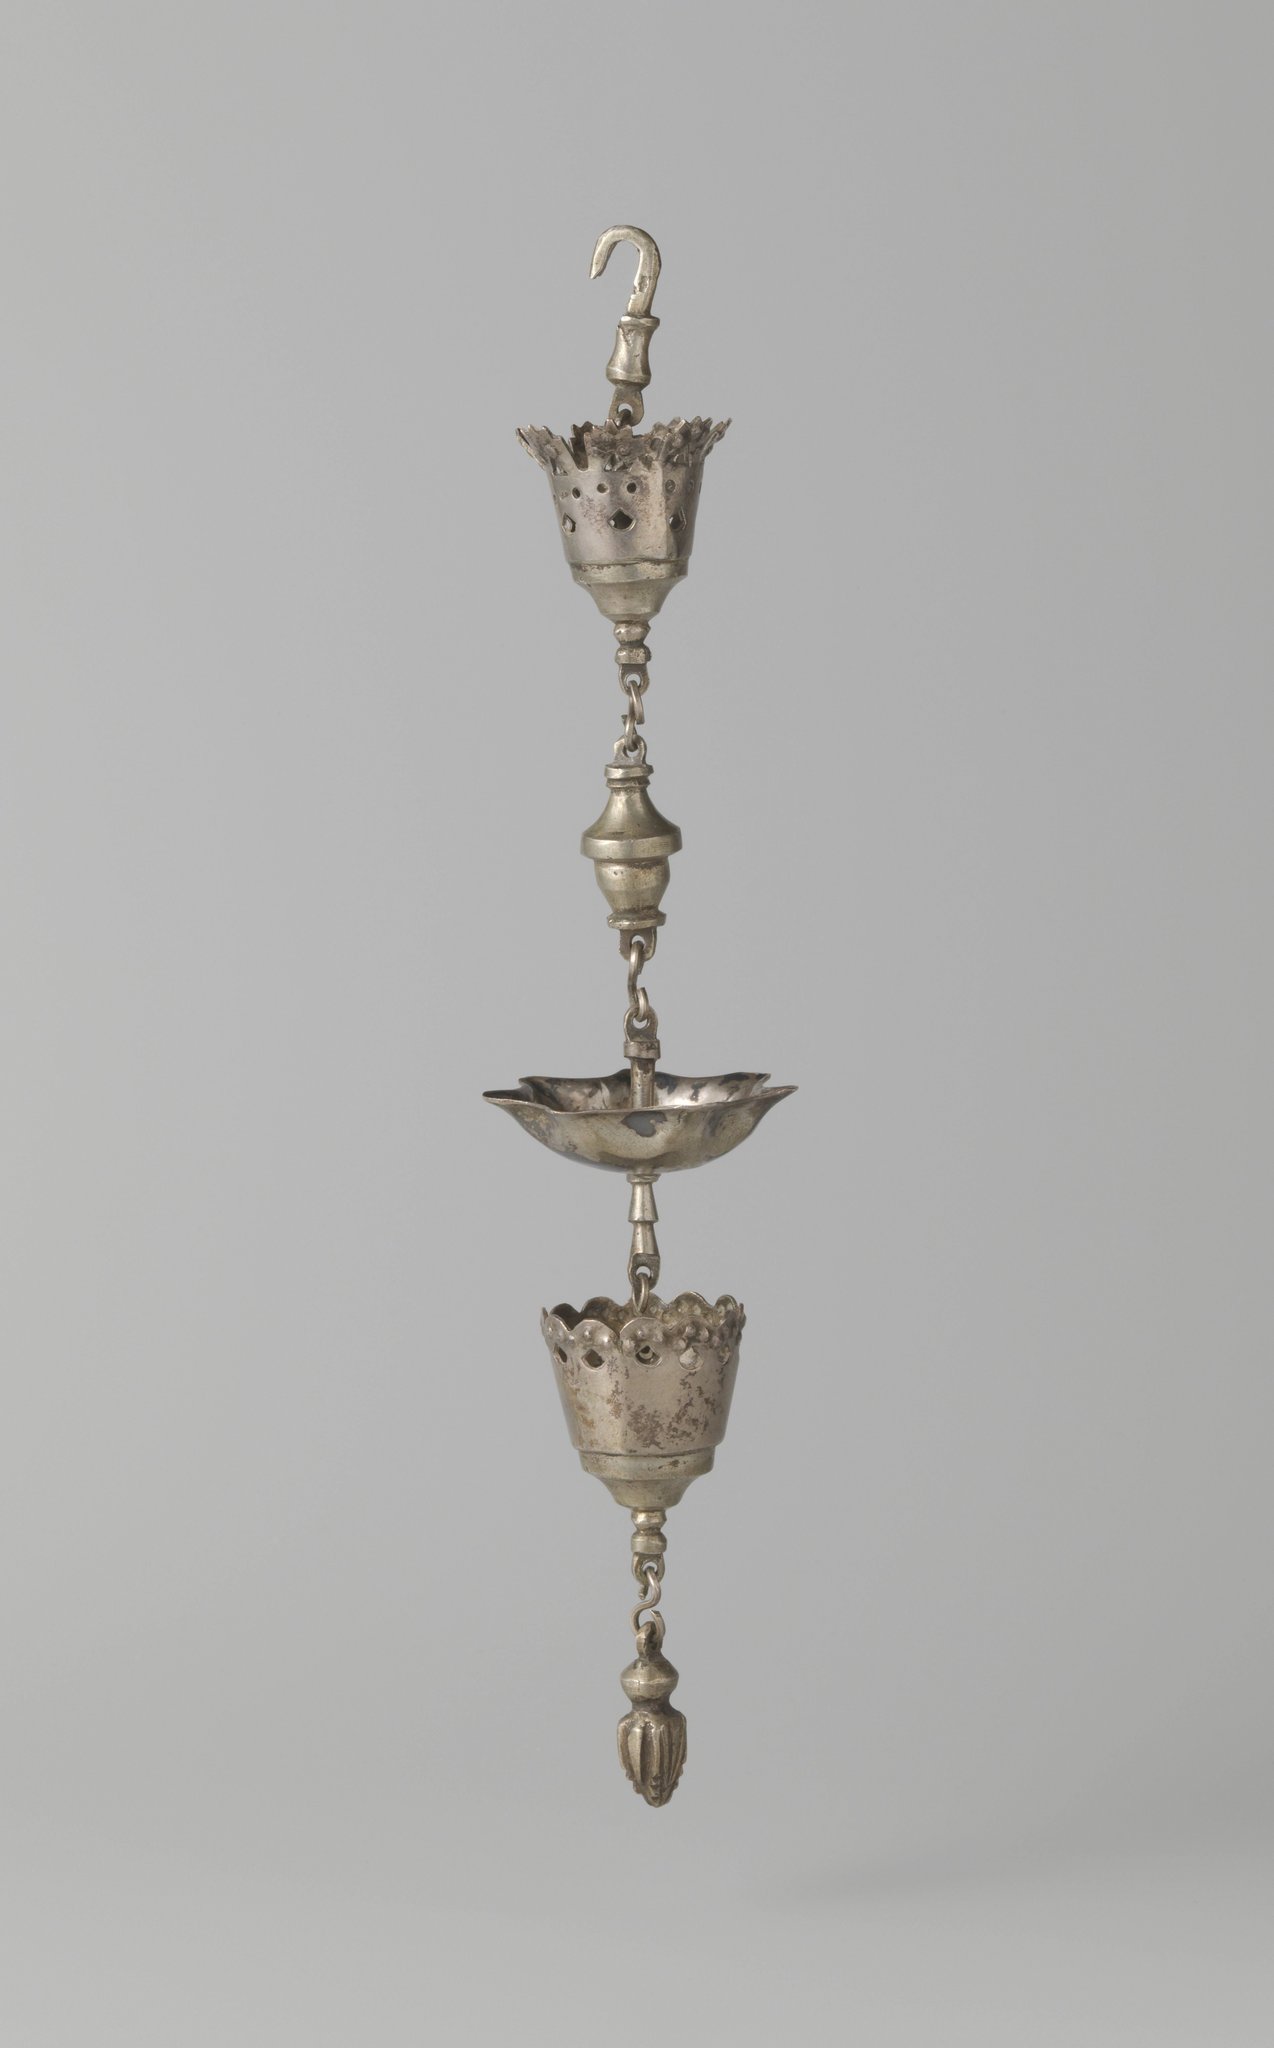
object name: miniature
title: Sabbathslamp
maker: Anonymous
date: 1813-1906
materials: silver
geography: netherlands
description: Aan elkaar hangen, verbonden door s-vormige tussenstukken drie branders die verschillend van vorm zijn en een balustervormige nodus. Aan de onderzijde bevindt zich een knopvormige hanger. De sabbathlamp is gemerkt met een zwaard.